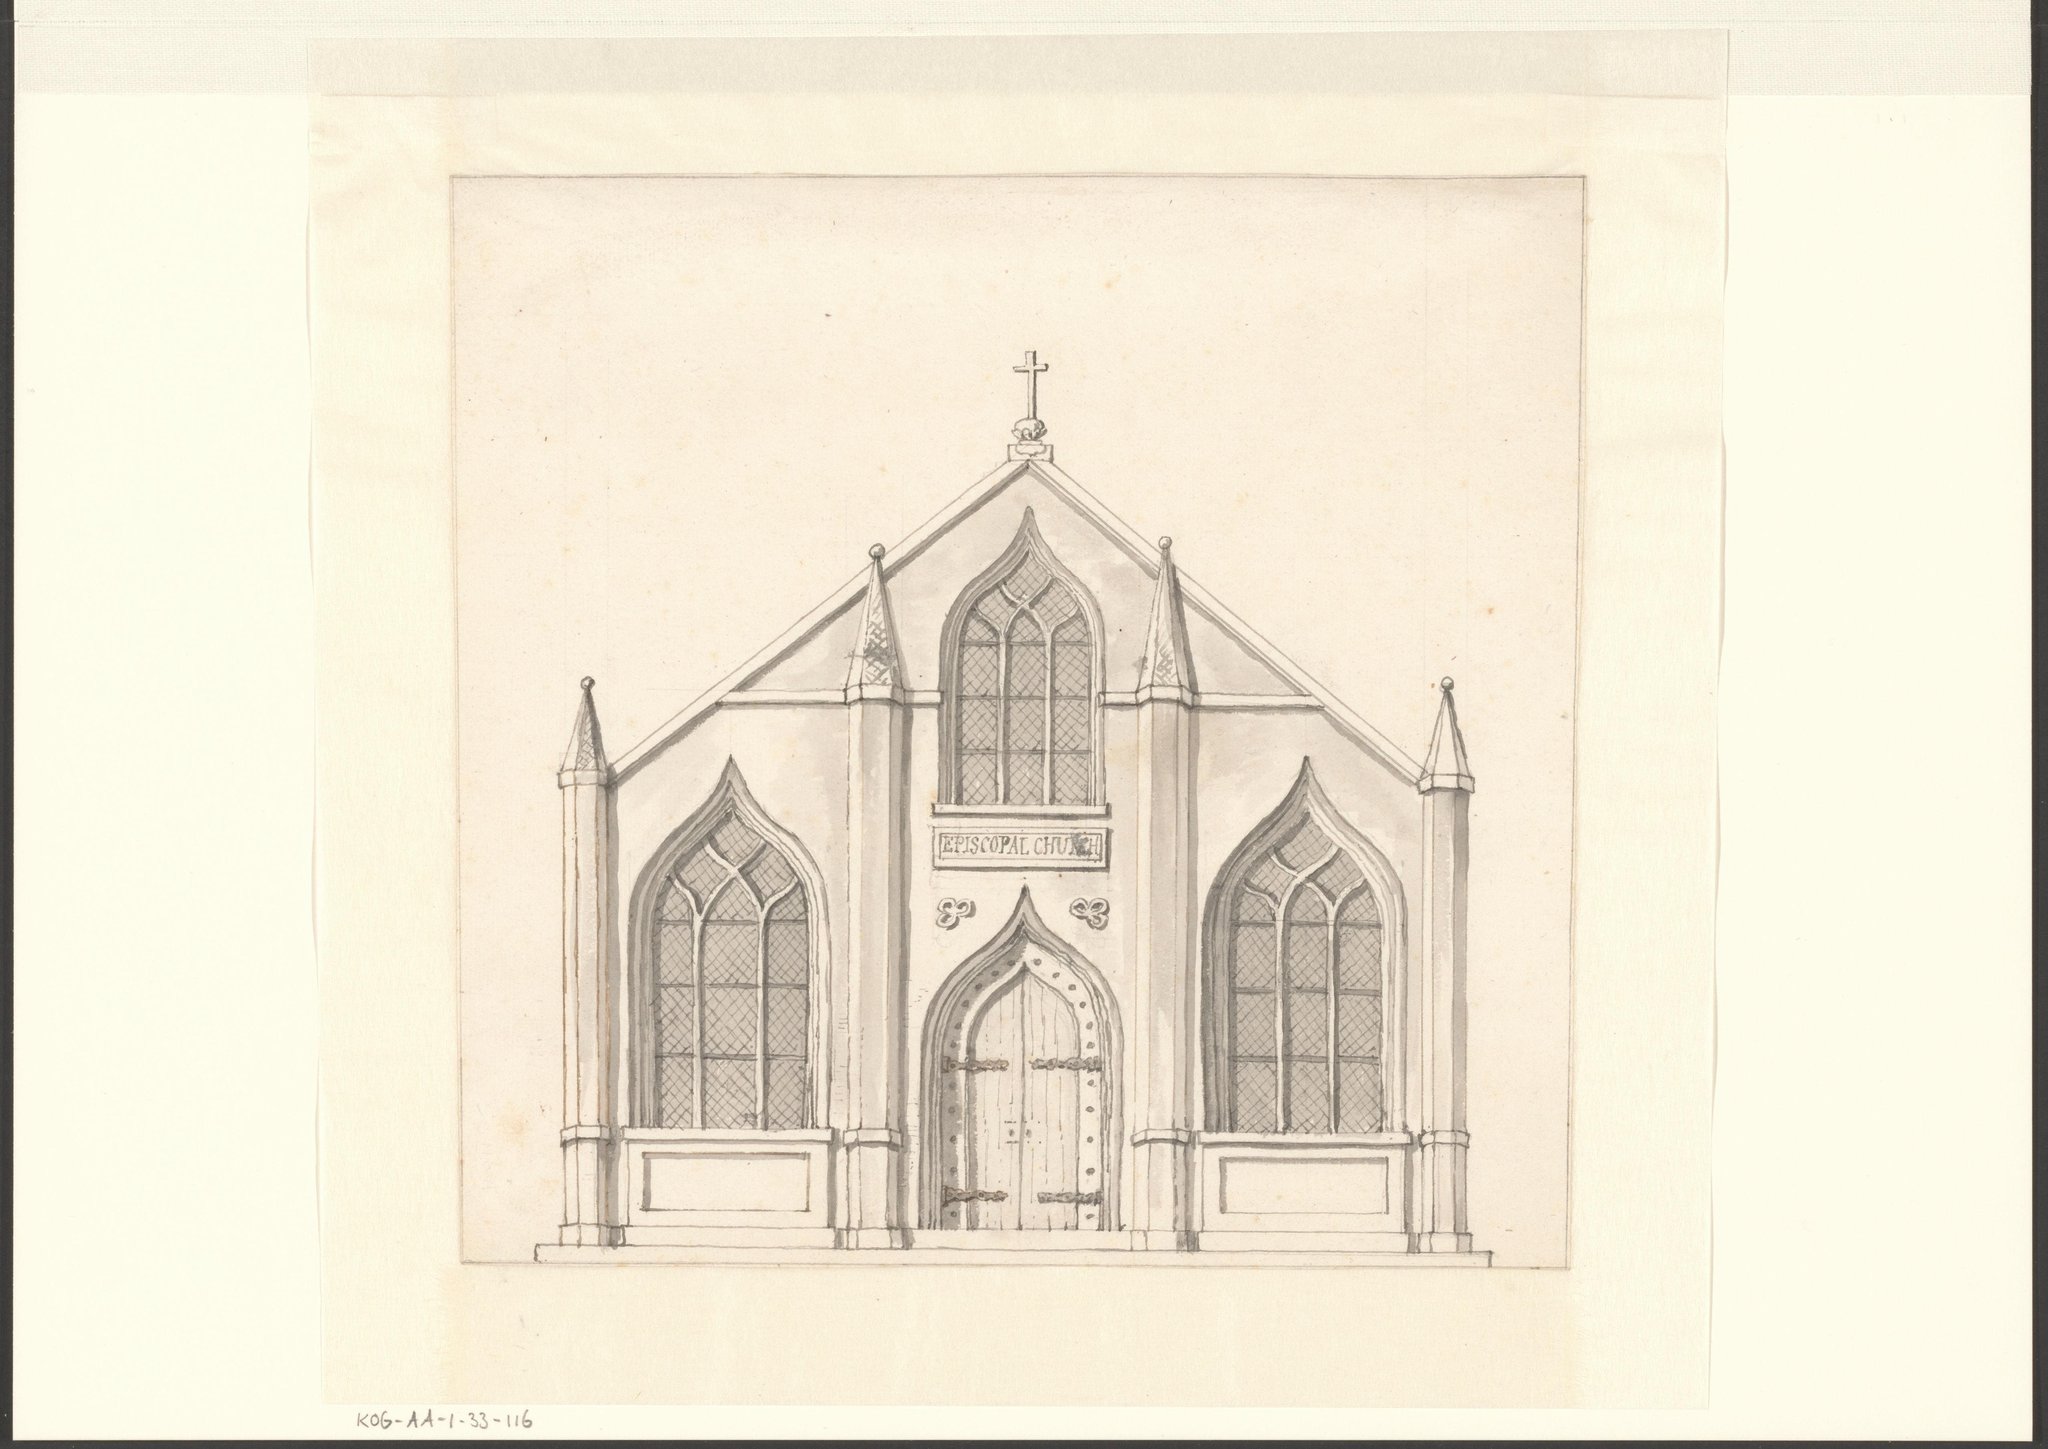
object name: drawing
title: Façade van de Christ Church te Amsterdam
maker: Anonymous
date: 1800-1850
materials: ink, paper, pencil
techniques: pen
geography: amsterdam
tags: city-view in general; 'veduta', church (exterior), front façade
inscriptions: inscription: ‘33:116’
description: Onderwerpsrubriek binnen de Atlas Amsterdam: Episcopale gemeente.